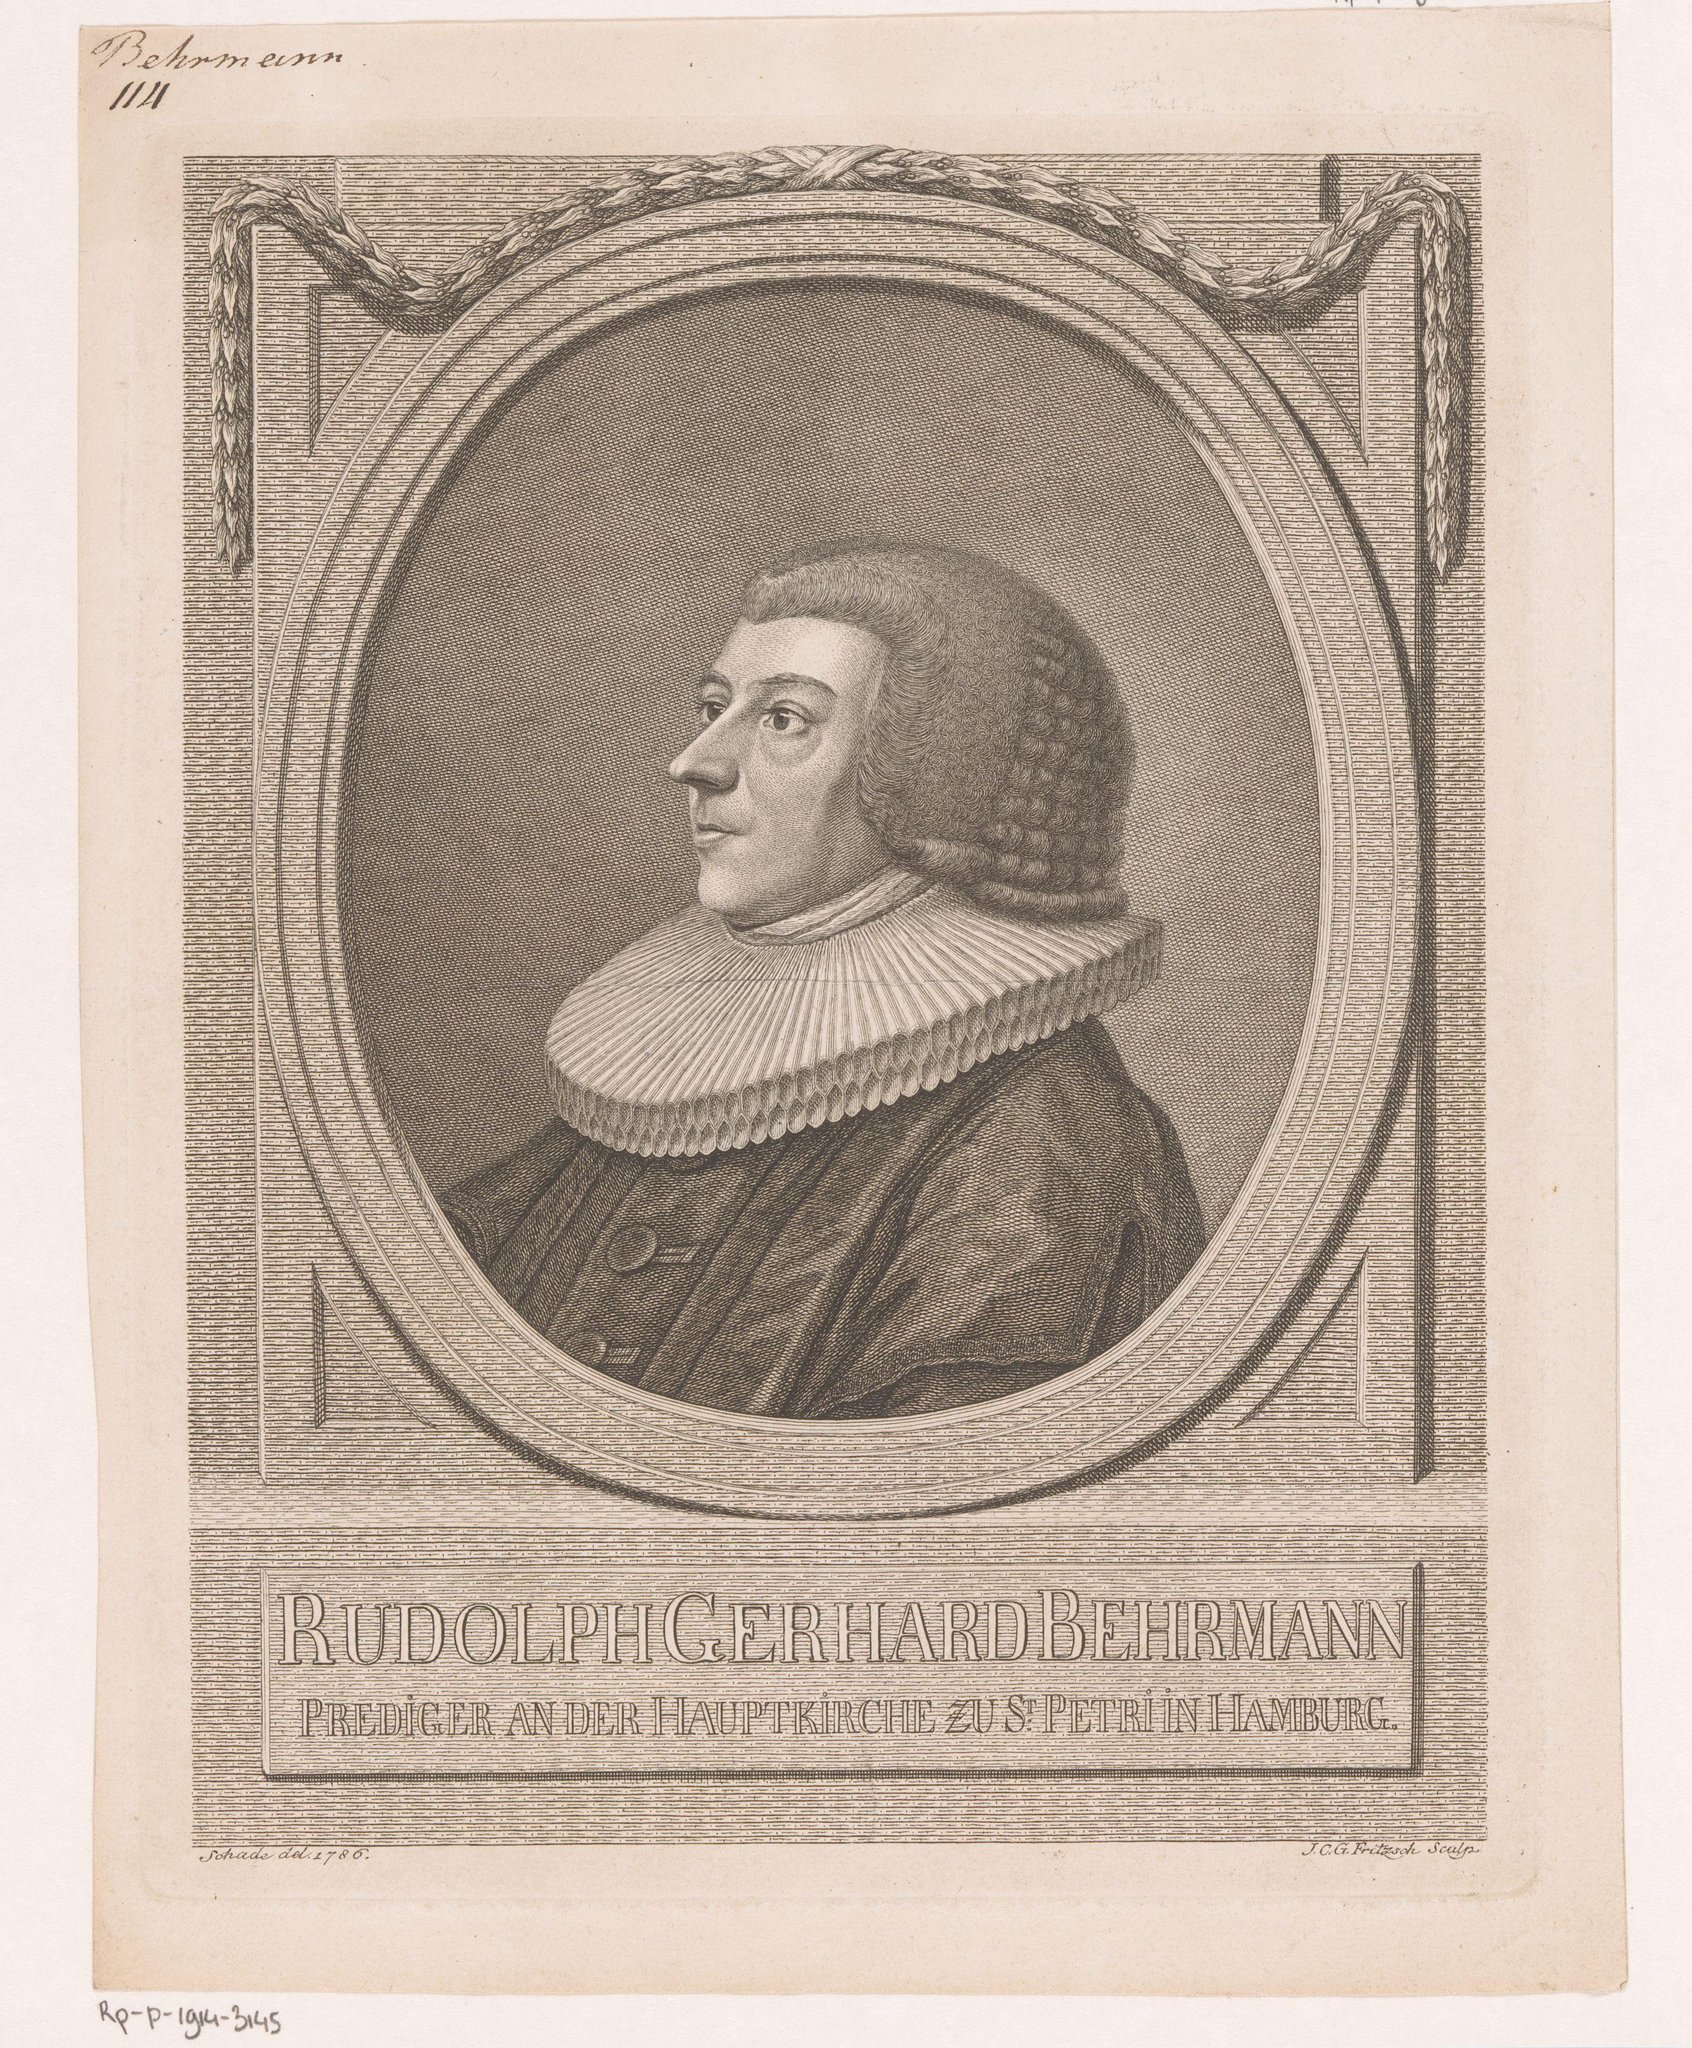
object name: print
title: Portret van Rudolph Gerhart Behrmann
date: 1786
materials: paper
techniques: engraving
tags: historical persons, ornament ~ festoon, garland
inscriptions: collector's mark: Lugt 2228